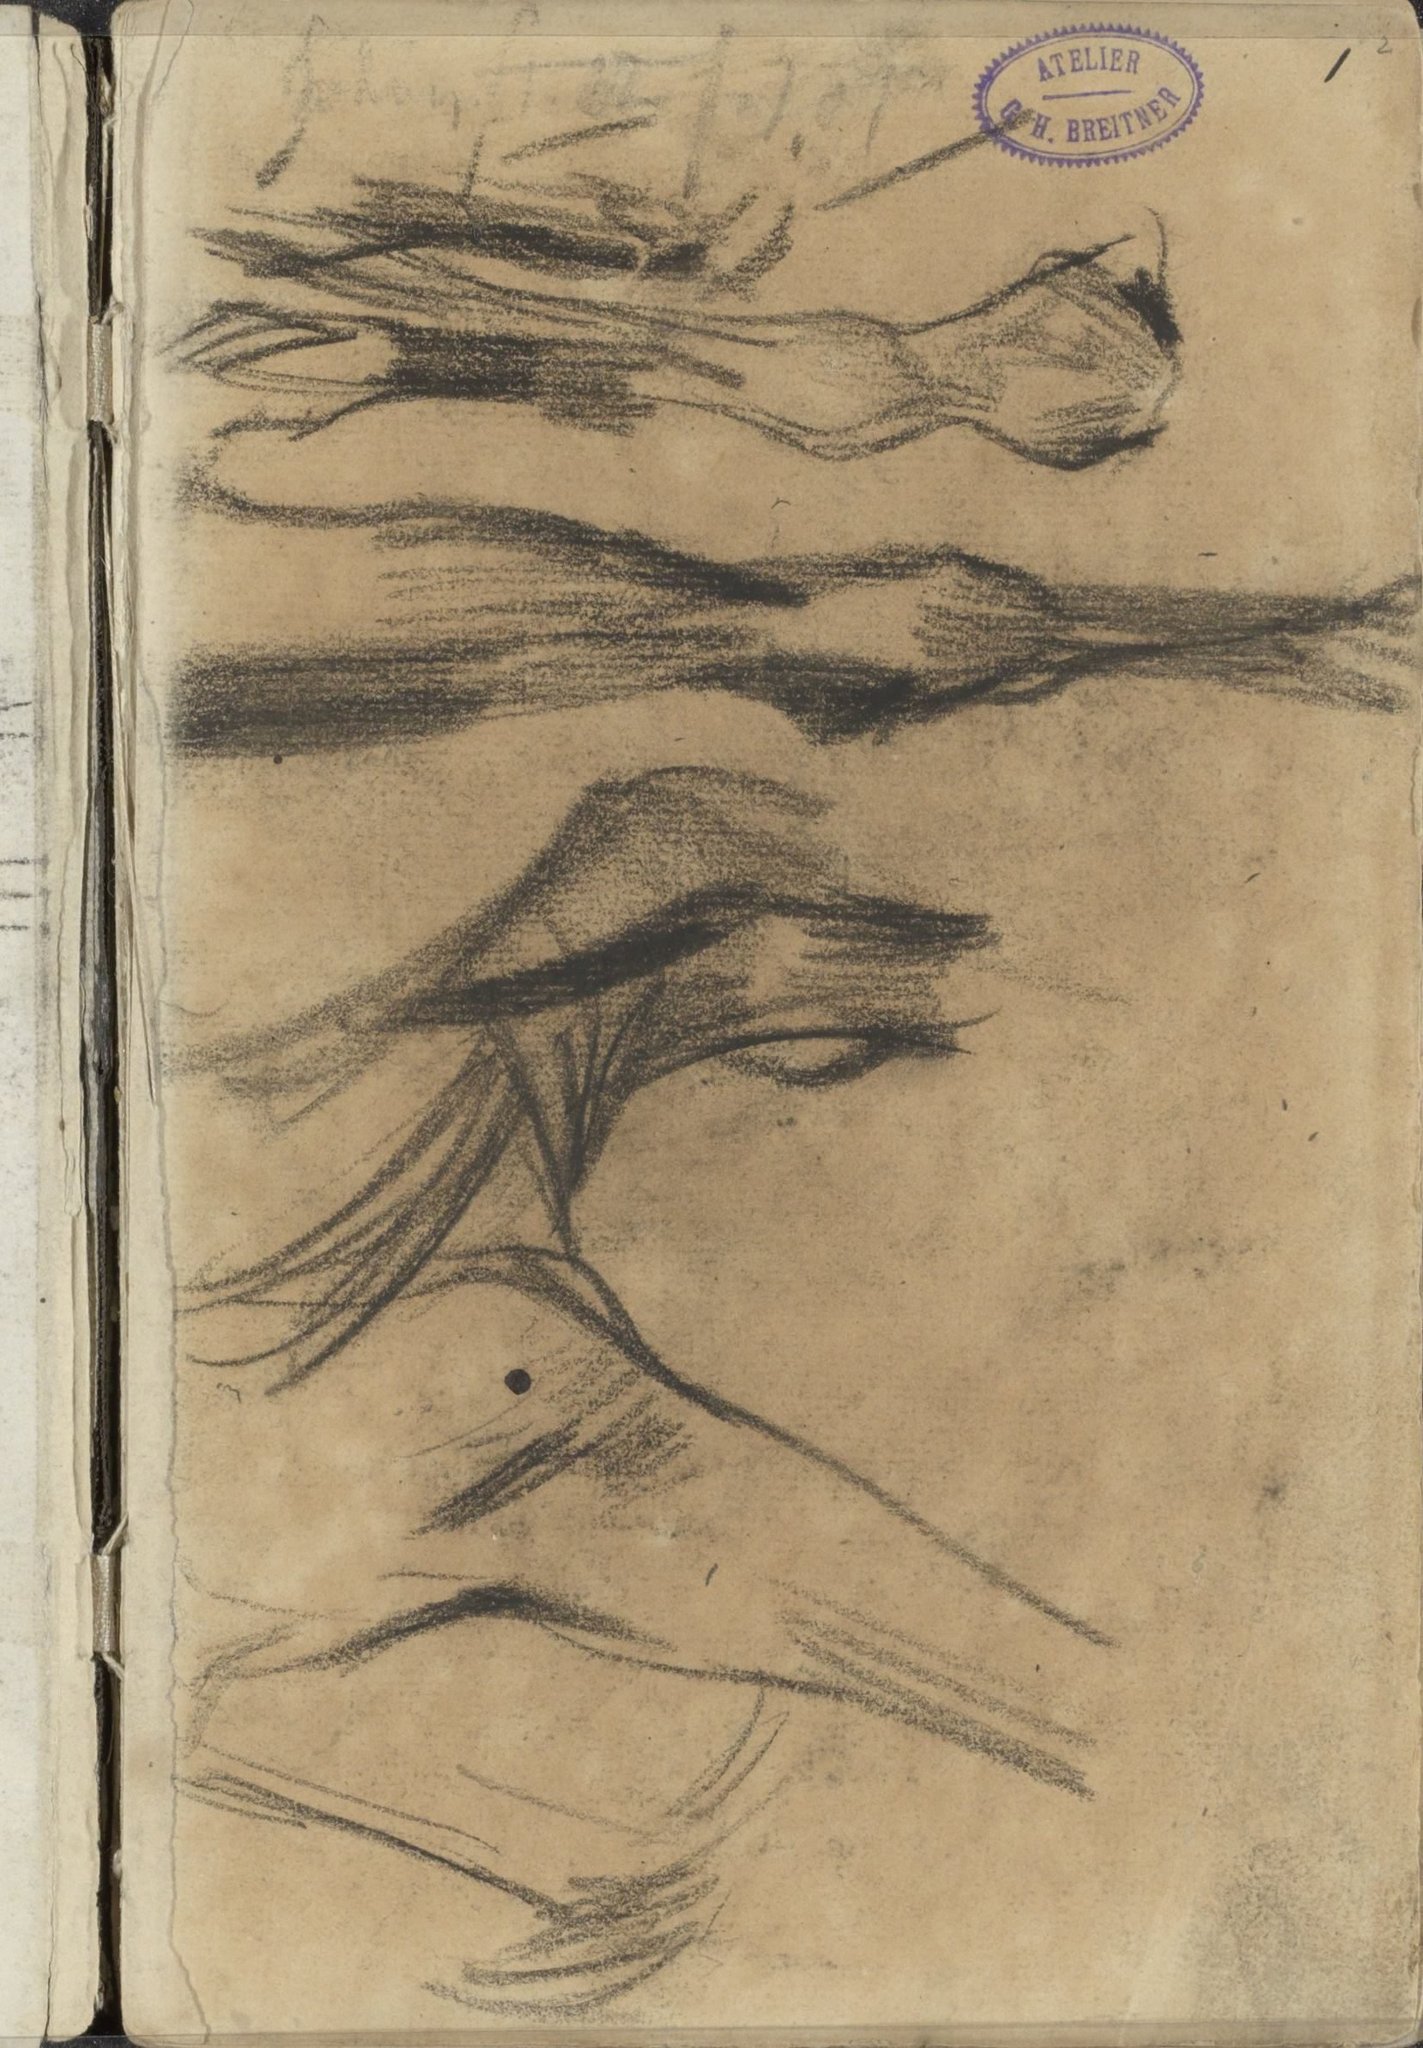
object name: sketchbook leaf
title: Paardenbenen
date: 1904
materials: chalk, paper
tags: horse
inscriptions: workshop stamp: Lugt 291d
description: Pagina 2 uit een schetsboek met 14 bladen.